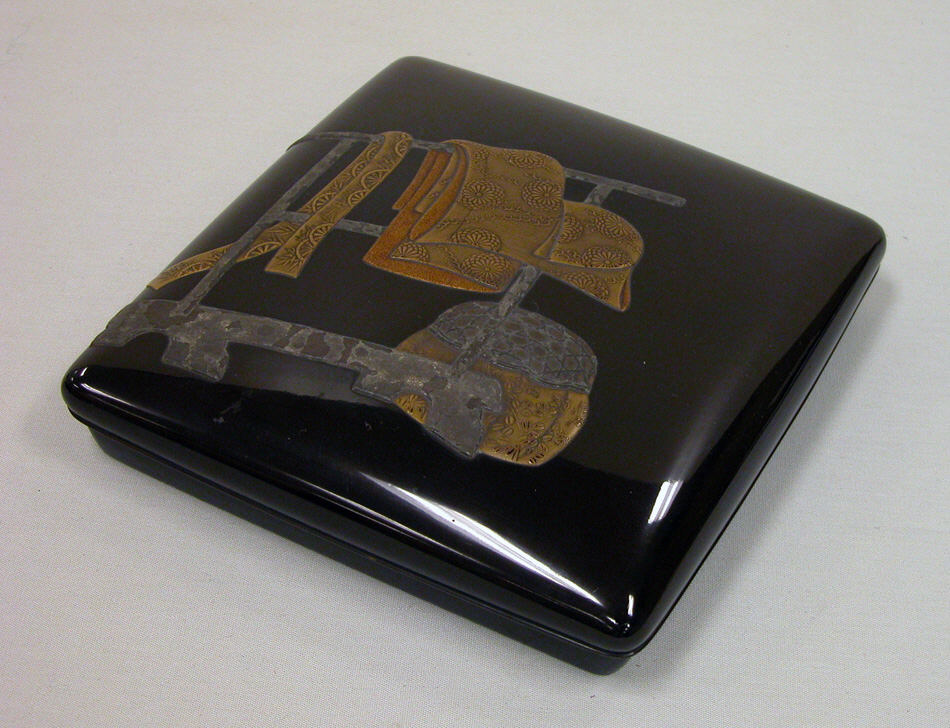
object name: writing box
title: Box for Writing Implements with Design of Kimono on Rack and Incense Burner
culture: japanese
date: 1801-1900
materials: gold, lacquer, silver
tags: flowers